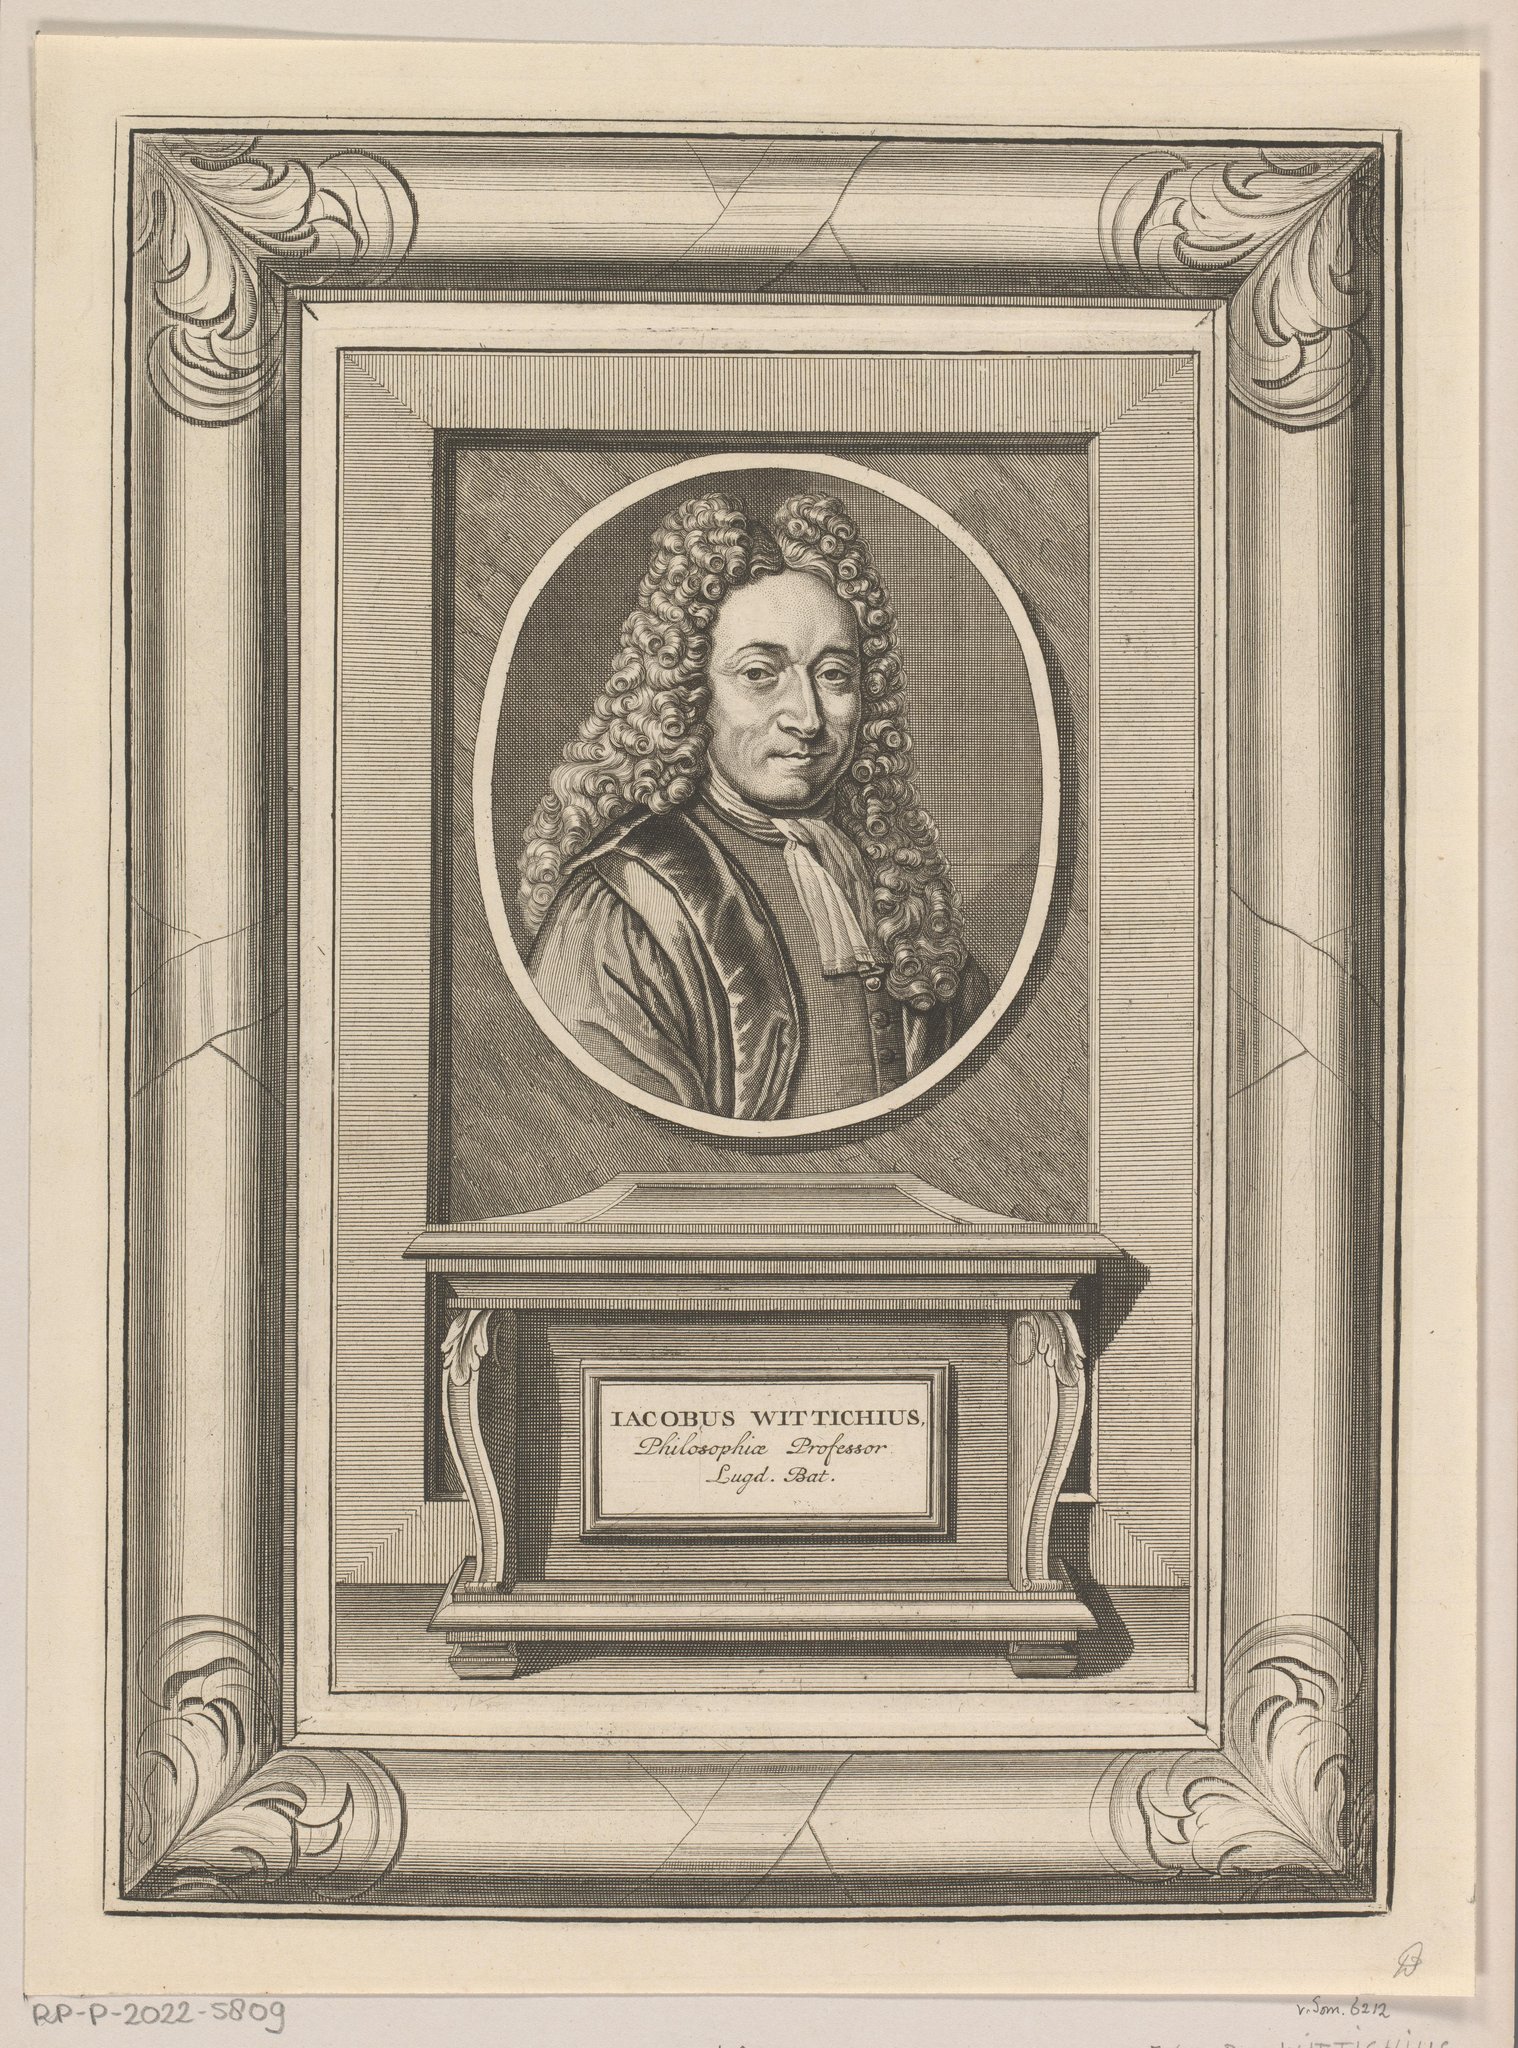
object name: print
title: Portret van Jacobus Wittichius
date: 1716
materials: paper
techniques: engraving, etching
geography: leiden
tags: scholar, philosopher, historical persons, professor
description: Met tweeregelig onderschrift in het Latijn.